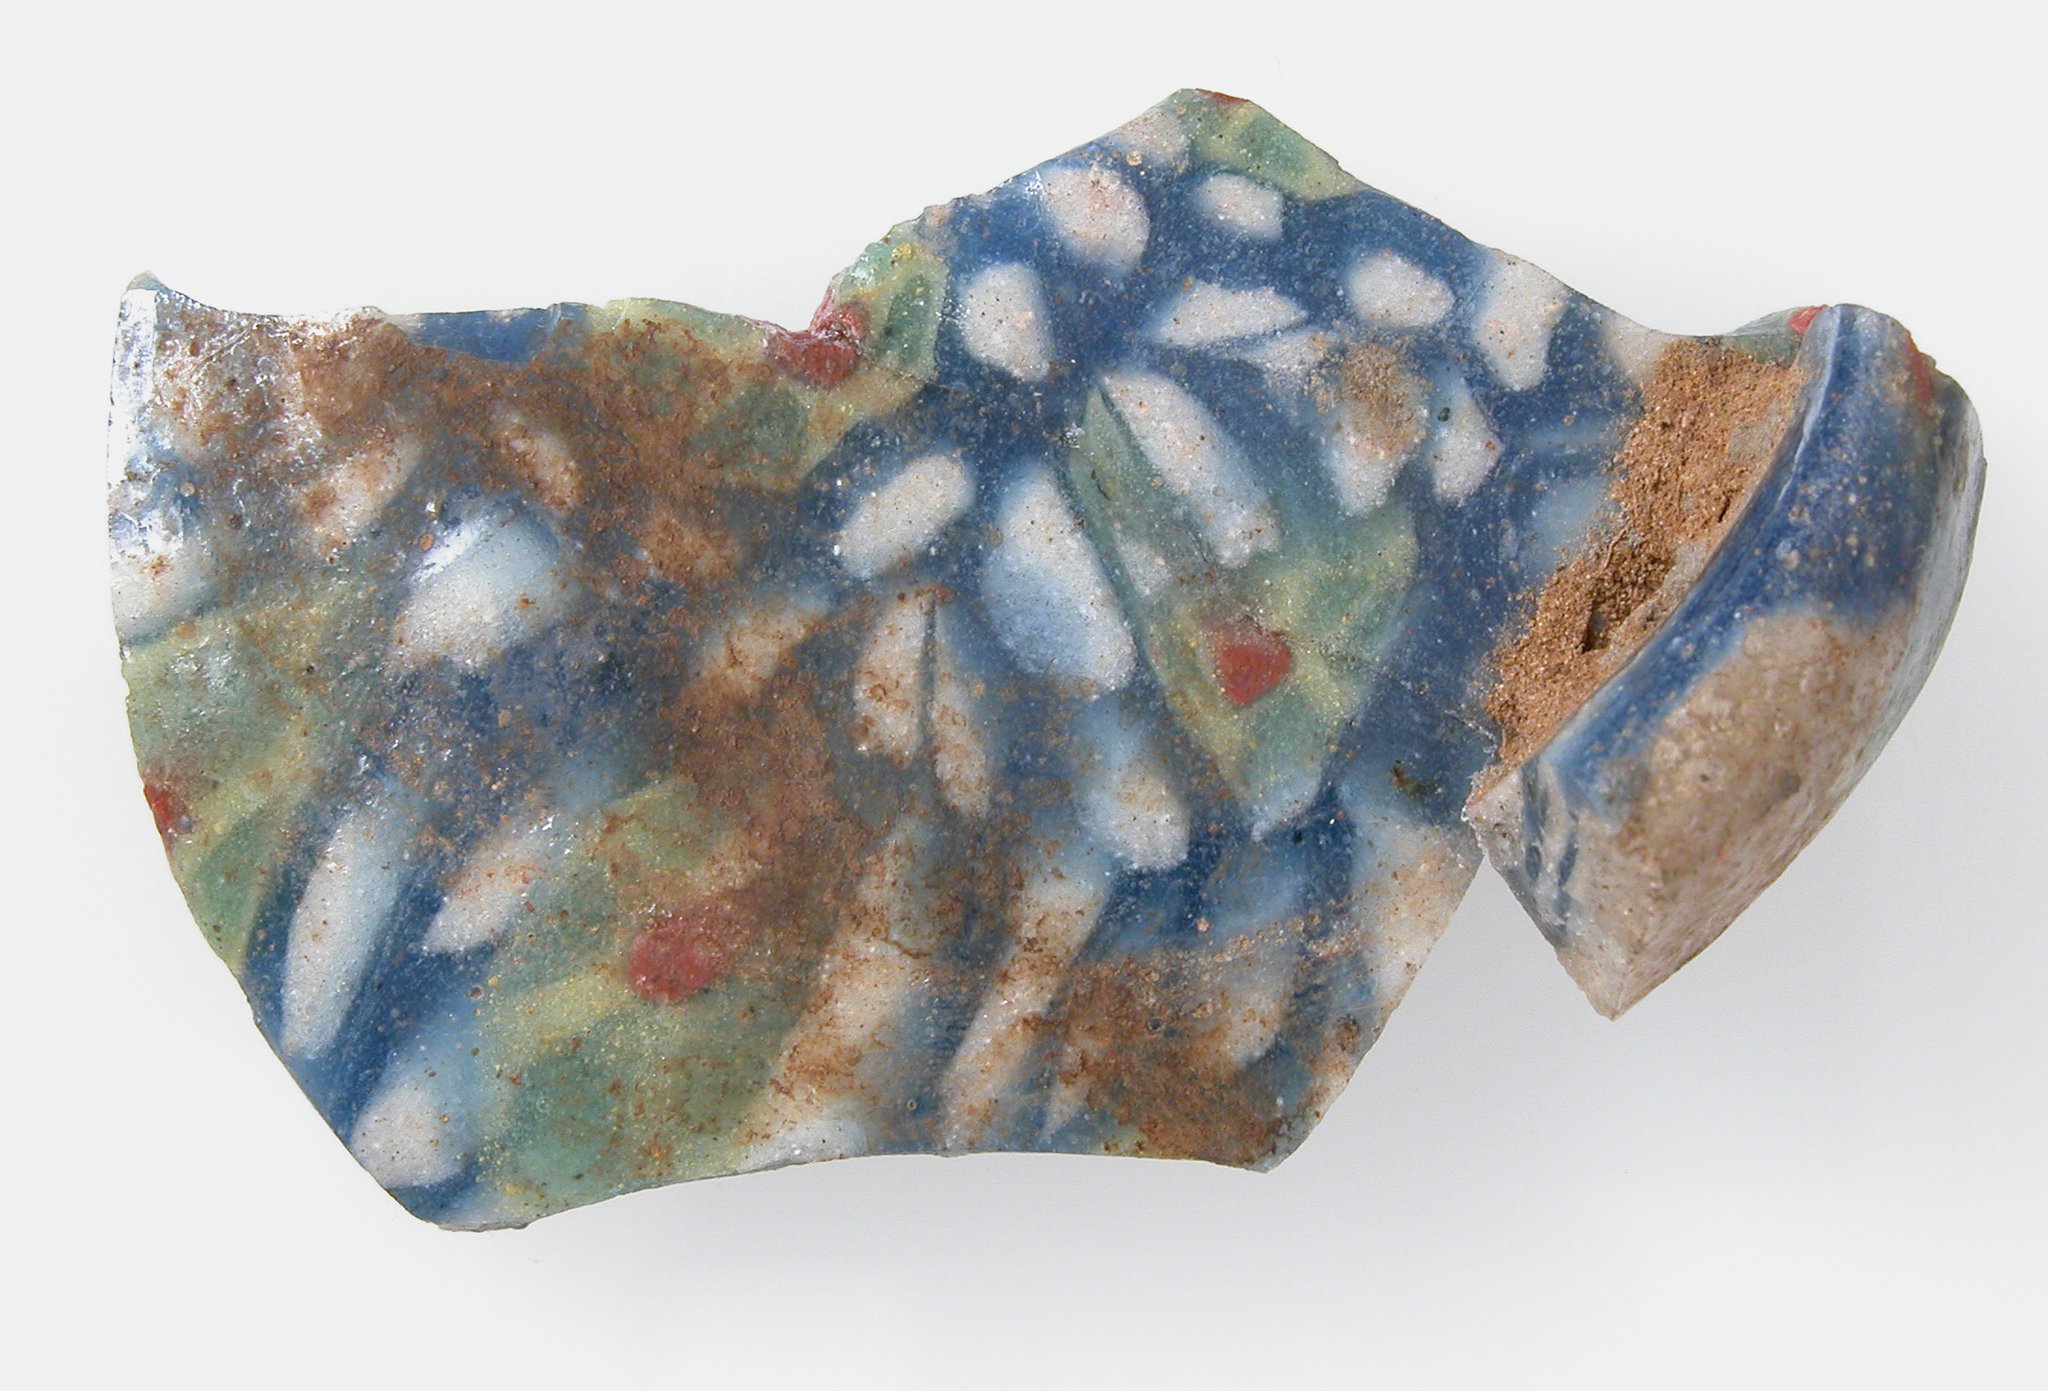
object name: fragment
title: Mosaic Glass Fragment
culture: coptic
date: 301-433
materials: glass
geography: egypt